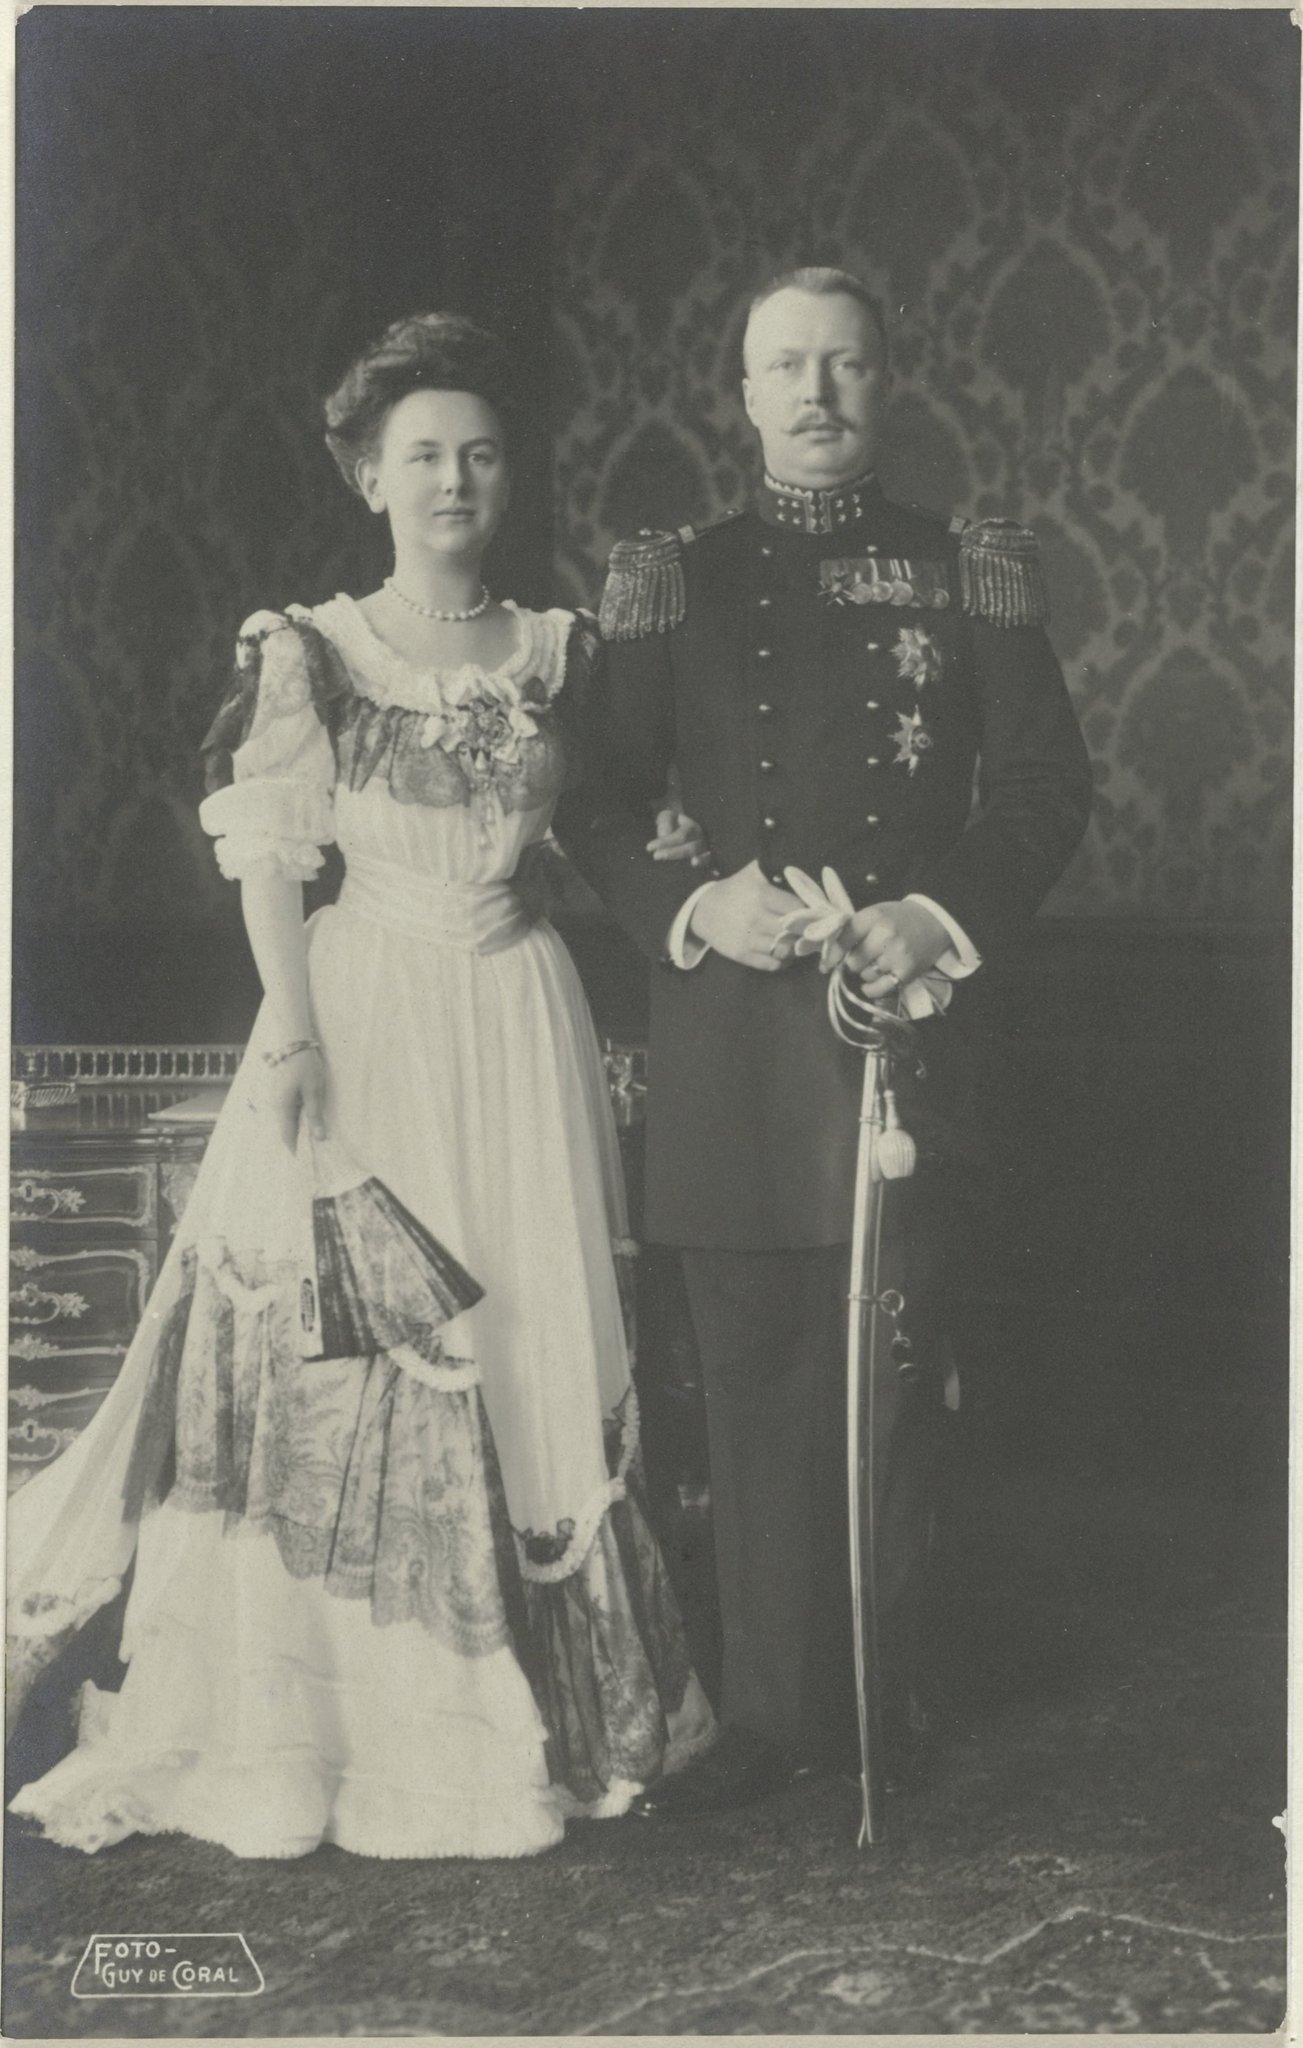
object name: photograph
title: Portret van Wilhelmina, koningin der Nederlanden, en Hendrik van Mecklenburg-Schwerin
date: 1906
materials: photographic support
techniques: photography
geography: netherlands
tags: the hague, print maker, wilhelmina of the netherlands, hendrik (prins der nederlanden (1876-1934))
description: De hier vermelde titel verwijst naar de hoogst verkregen titel van de geportretteerde, niet per se naar de titel die de geportretteerde op deze voorstelling draagt.